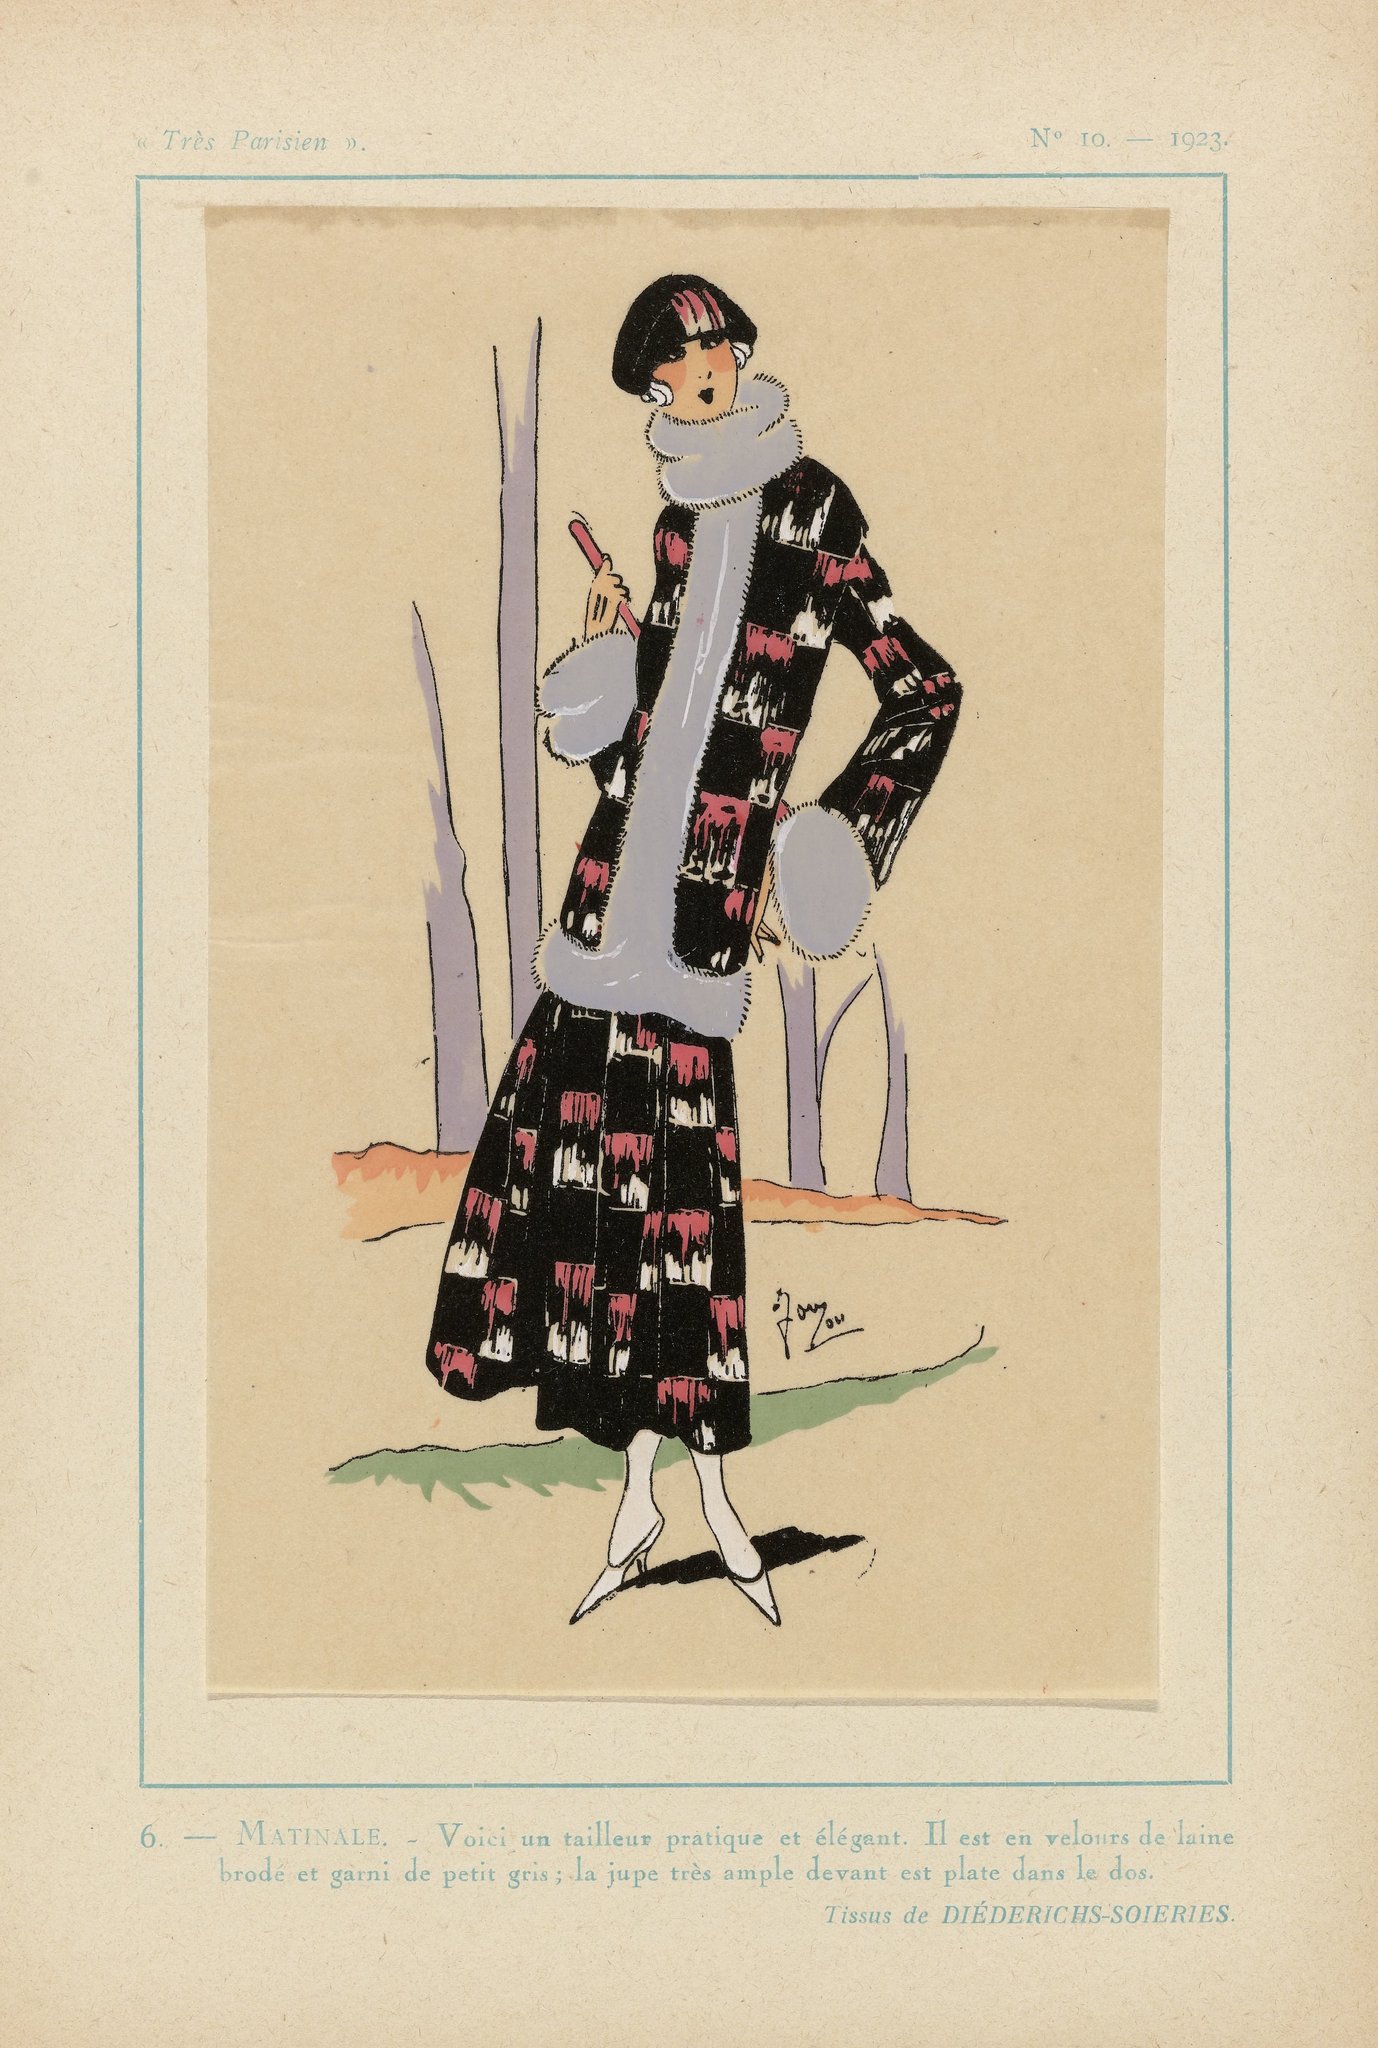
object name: fashion print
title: Très Parisien, 1923, No 10: 6. - MATINALE. - Voici un tailleur pratique...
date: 1923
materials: paper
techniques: hand coloring, letterpress printing, lithography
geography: paris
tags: embroidery (ornamentation) (+ women's clothes), ensembles of pieces of clothing (suit) (+ women's clothes), border, ribbon, braid (+ fur used for clothes), coat (+ women's clothes), fashion plates, head-gear: hat (+ women's clothes), skirt (+ women's clothes)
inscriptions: caption: ‘6. - MATINALE. - Voici un tailleur pratique et élégant. Il est en velours de laine brodé et garni de petit gris; la jupe très ample devant est plate dans le dos. / Tissus de Diéderichs-Soieries.’, title: ‘Très Parisien / No 10. - 1923’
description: Tailleur (mantelpak) van geborduurde 'velours de laine' en gegarneerd met 'petit gris'. Wijde rok die aan de achterkant recht is. Stoffen van Diéderichs-Soieries. Prent uit het modetijdschrift Très Parisien (1920-1936).